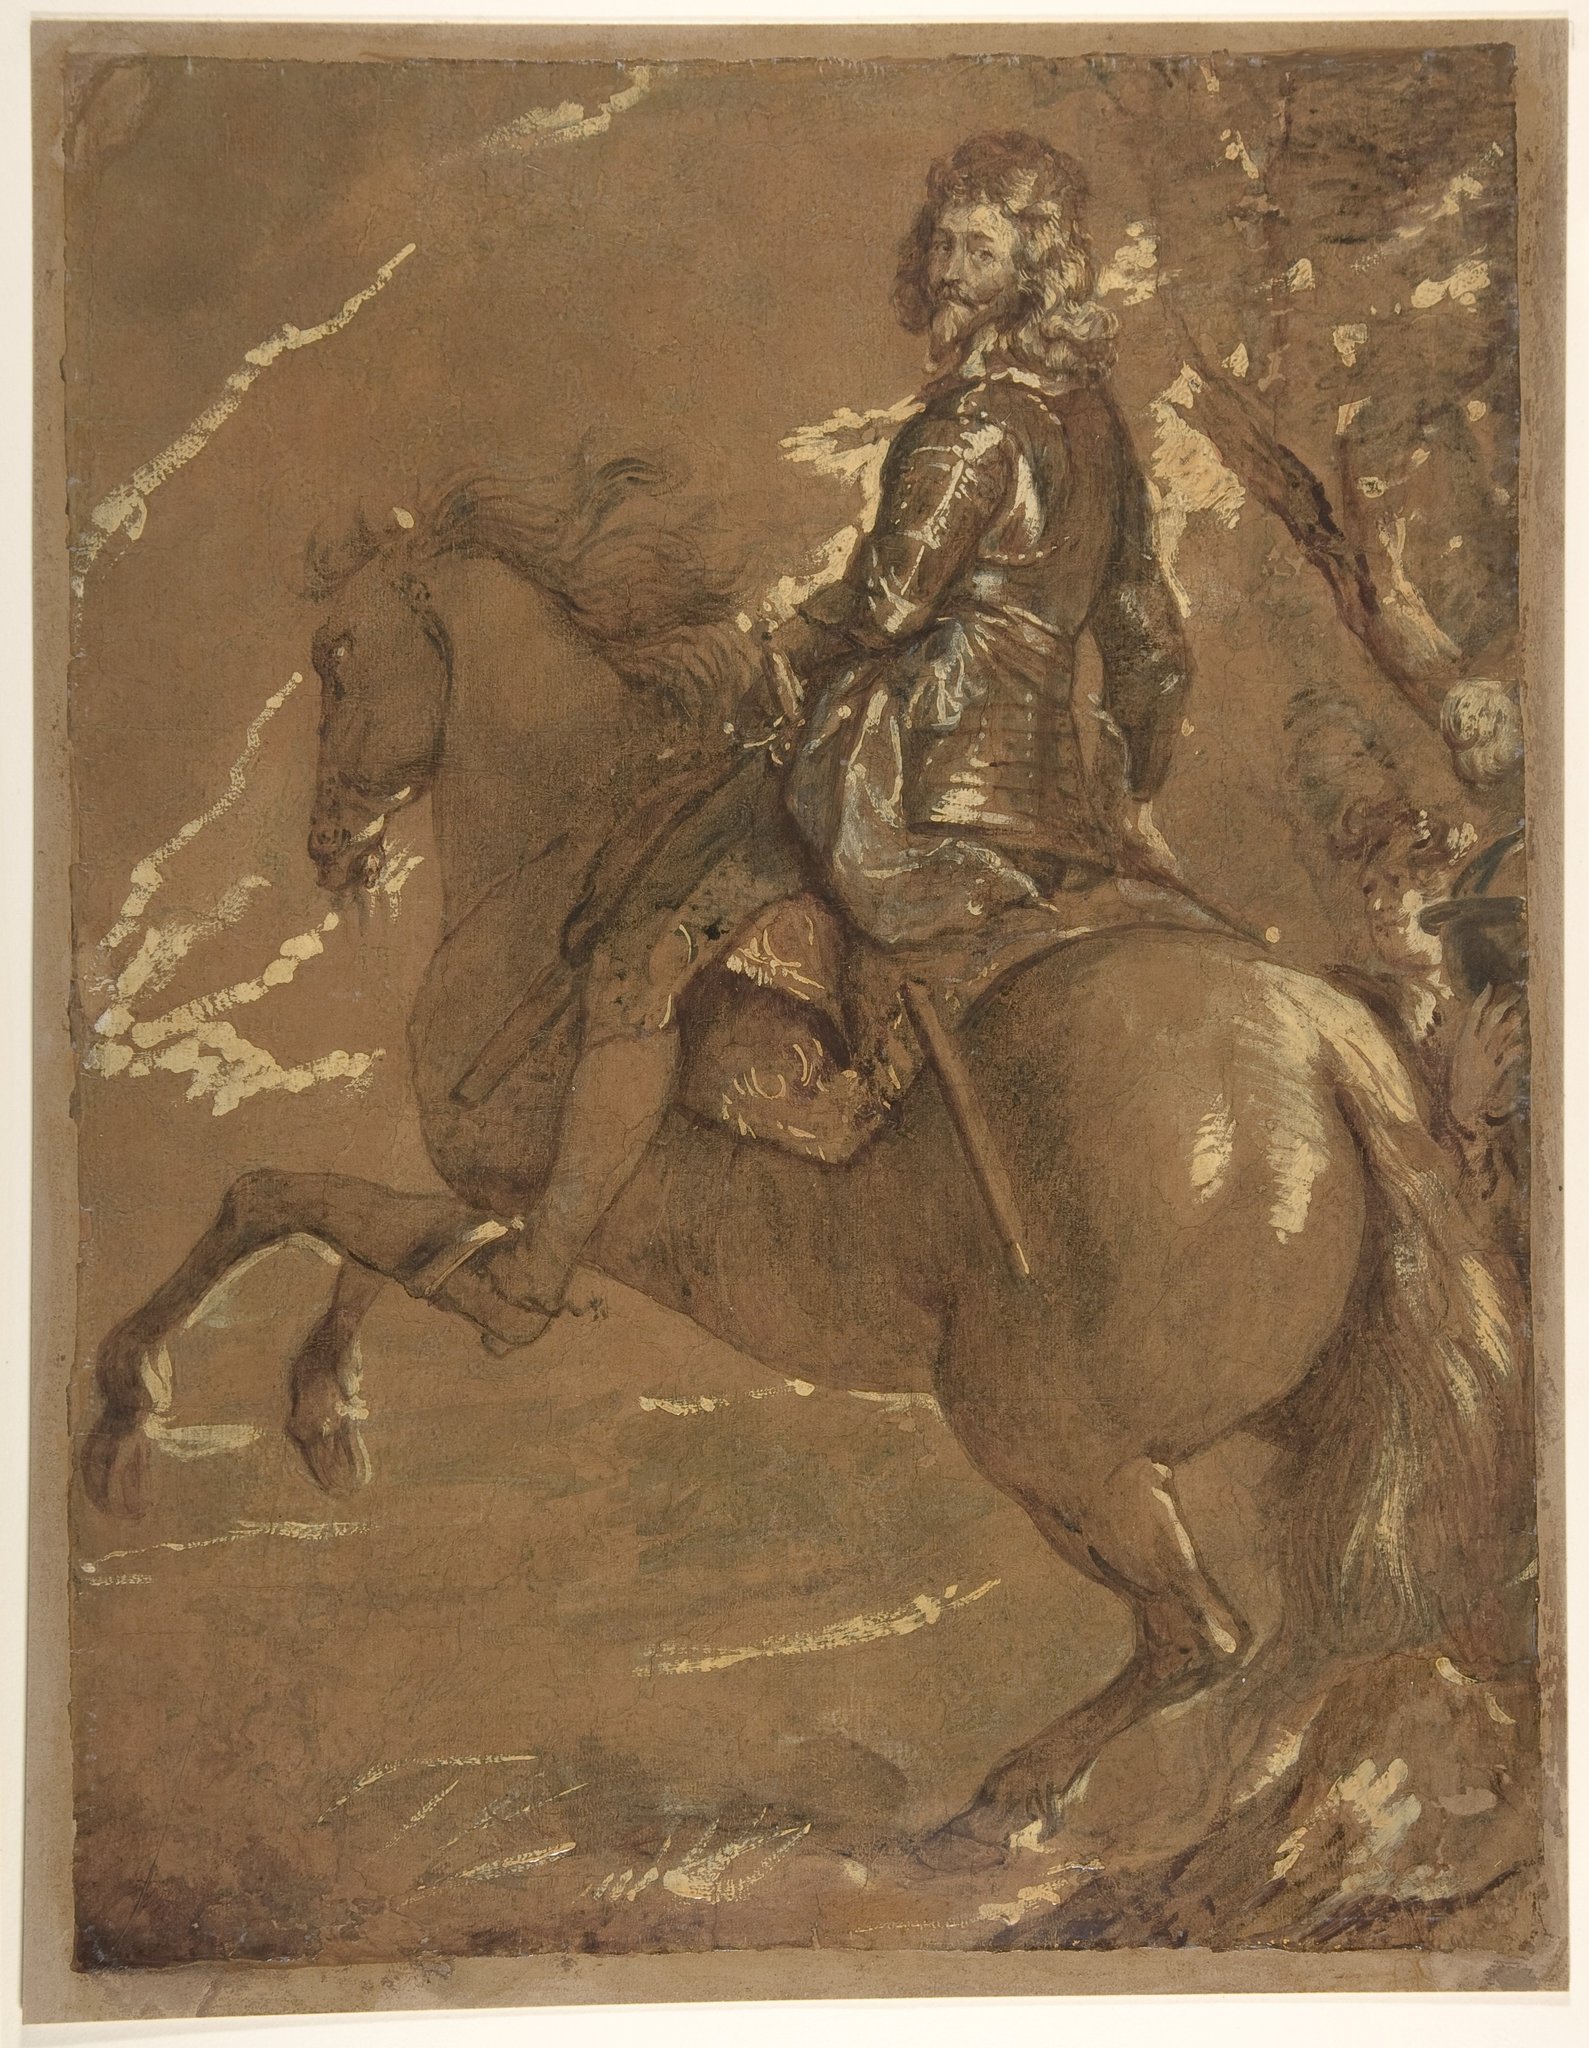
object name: drawing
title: Albert de Ligne, Count of Arenberg, Prince of Brabançon (1600–1674)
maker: anthony van dyck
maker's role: artist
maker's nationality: flemish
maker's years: 1599-1641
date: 1601-1700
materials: oil, watercolor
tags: princes,horses